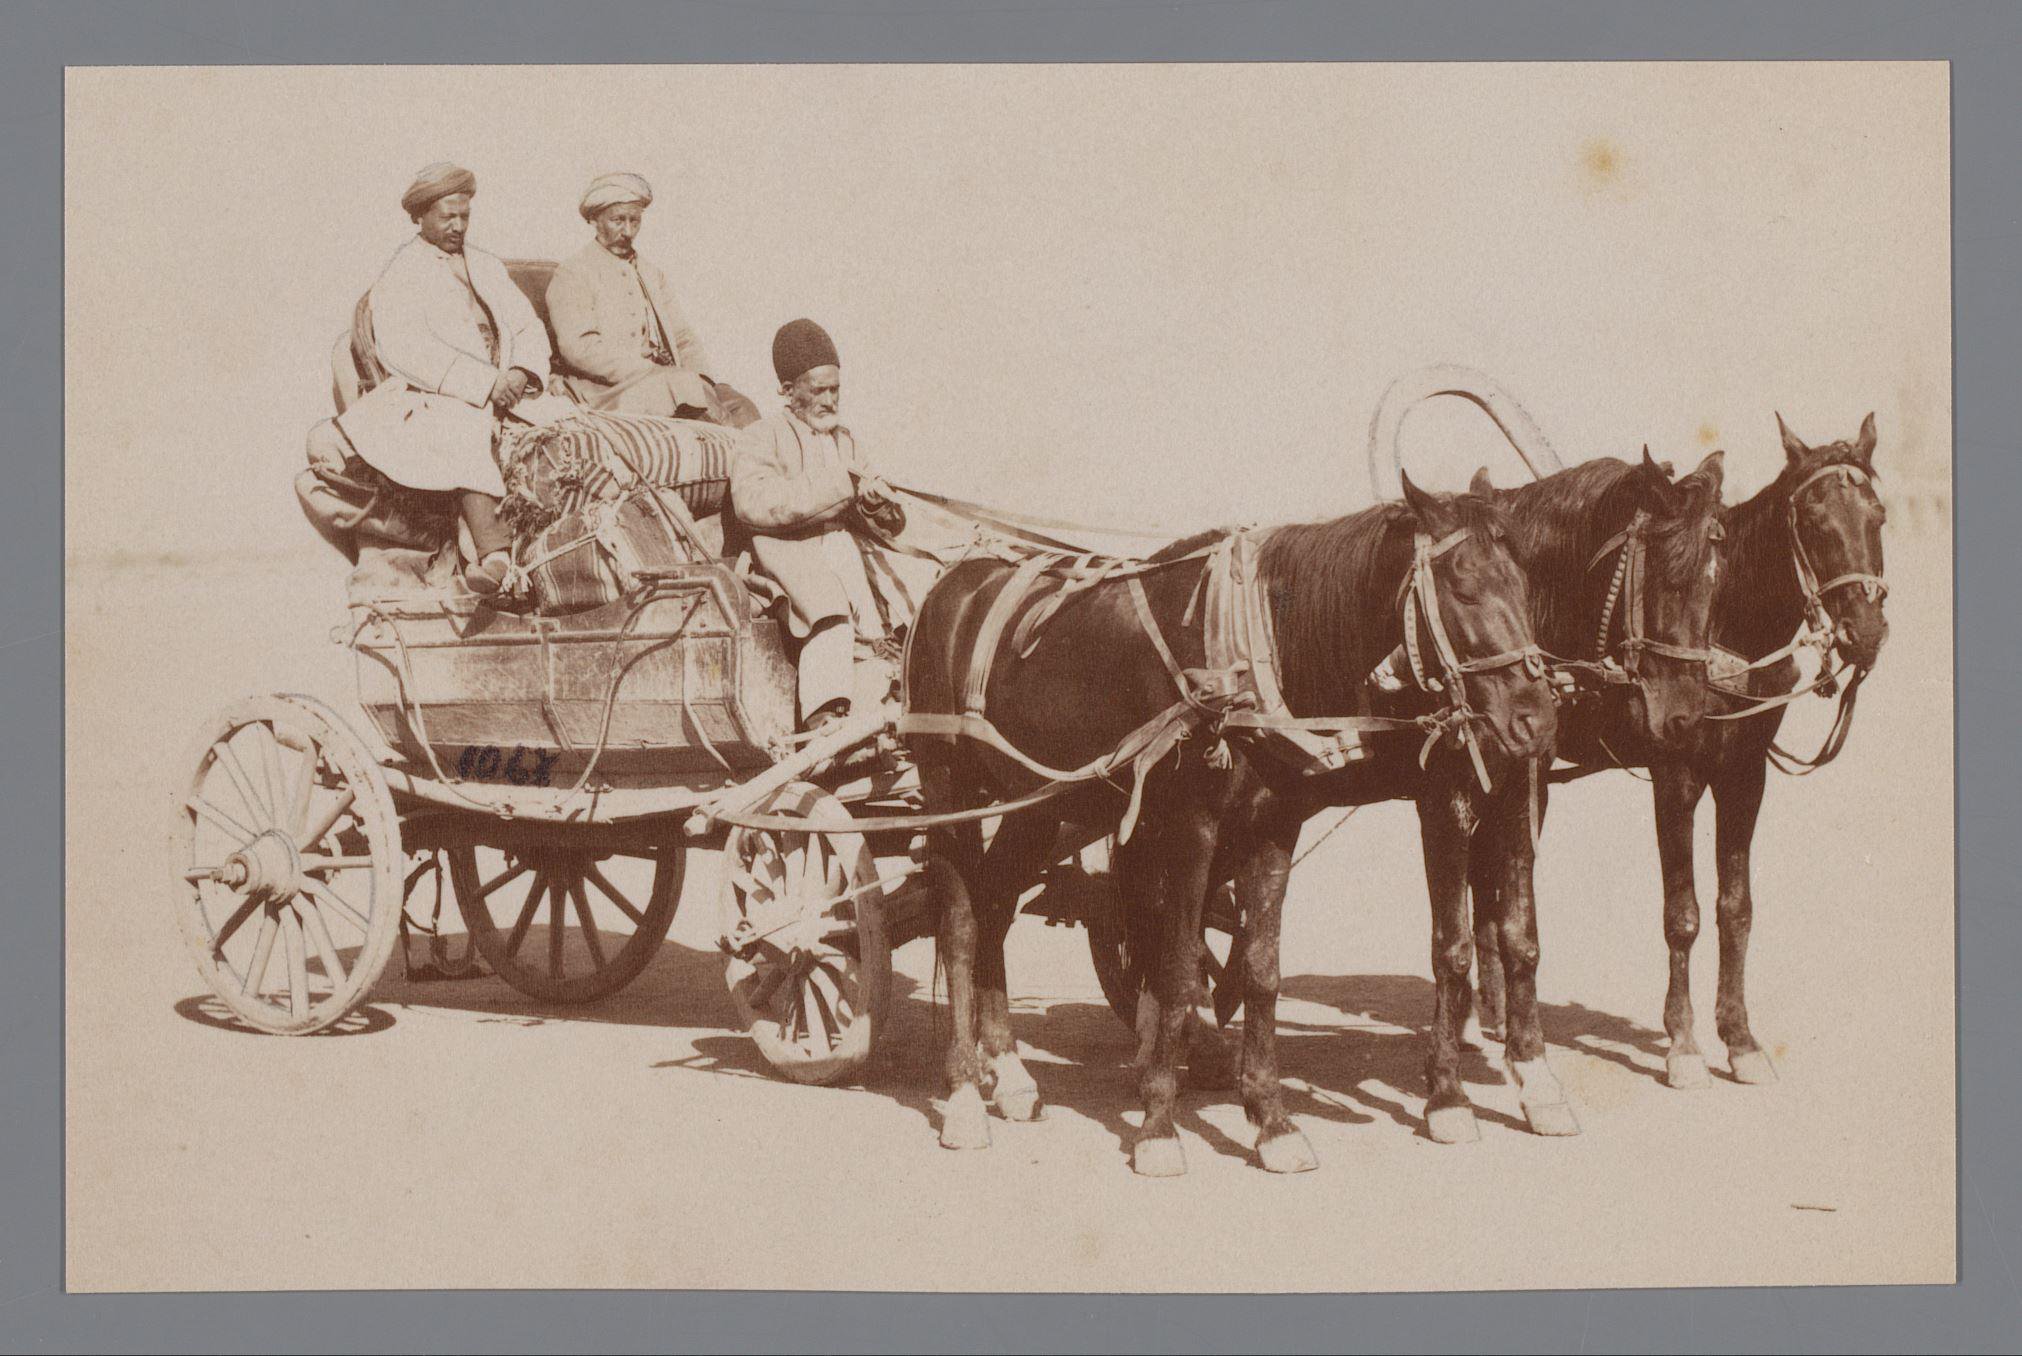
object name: photograph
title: Drie mannen in een paard en wagen, Iran [?]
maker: antoine sevruguin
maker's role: fotograaf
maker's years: 1840-1933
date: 1880-1910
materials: paper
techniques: albumen print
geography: iran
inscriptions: inscription: ‘La route de Kazrin//Keneabeh [?]’, number: ‘995’, inscription: ‘10cm breed//nummer//wegmaken’, number: ‘22.’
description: Drie mannen in een paard en wagen, Iran [?].